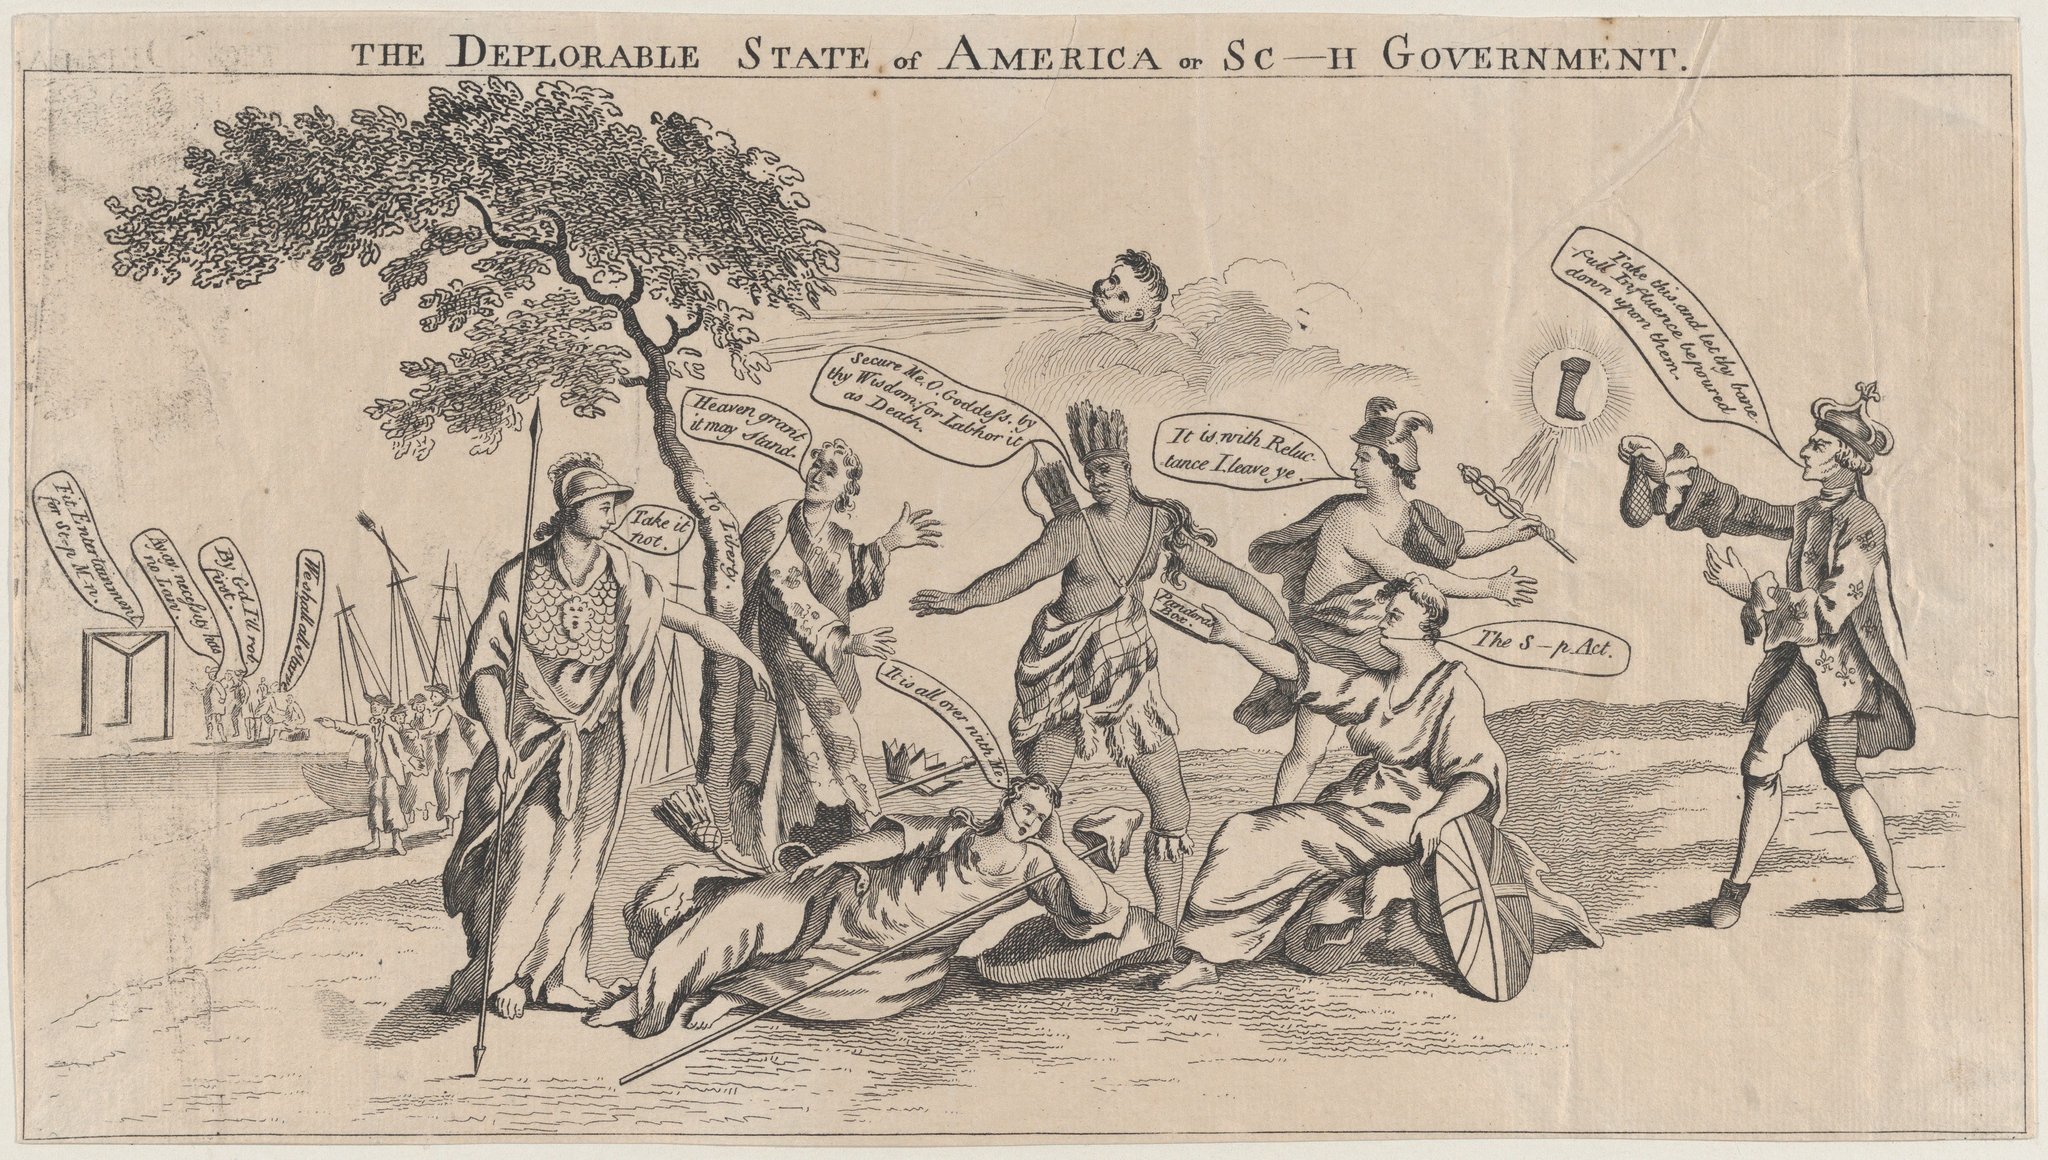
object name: print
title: The Deplorable State of America, or Sc___h Government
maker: anonymous, british, 18th century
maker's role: artist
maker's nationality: british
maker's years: 1700-1800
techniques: etching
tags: satire,american revolution,mercury,minerva,politics